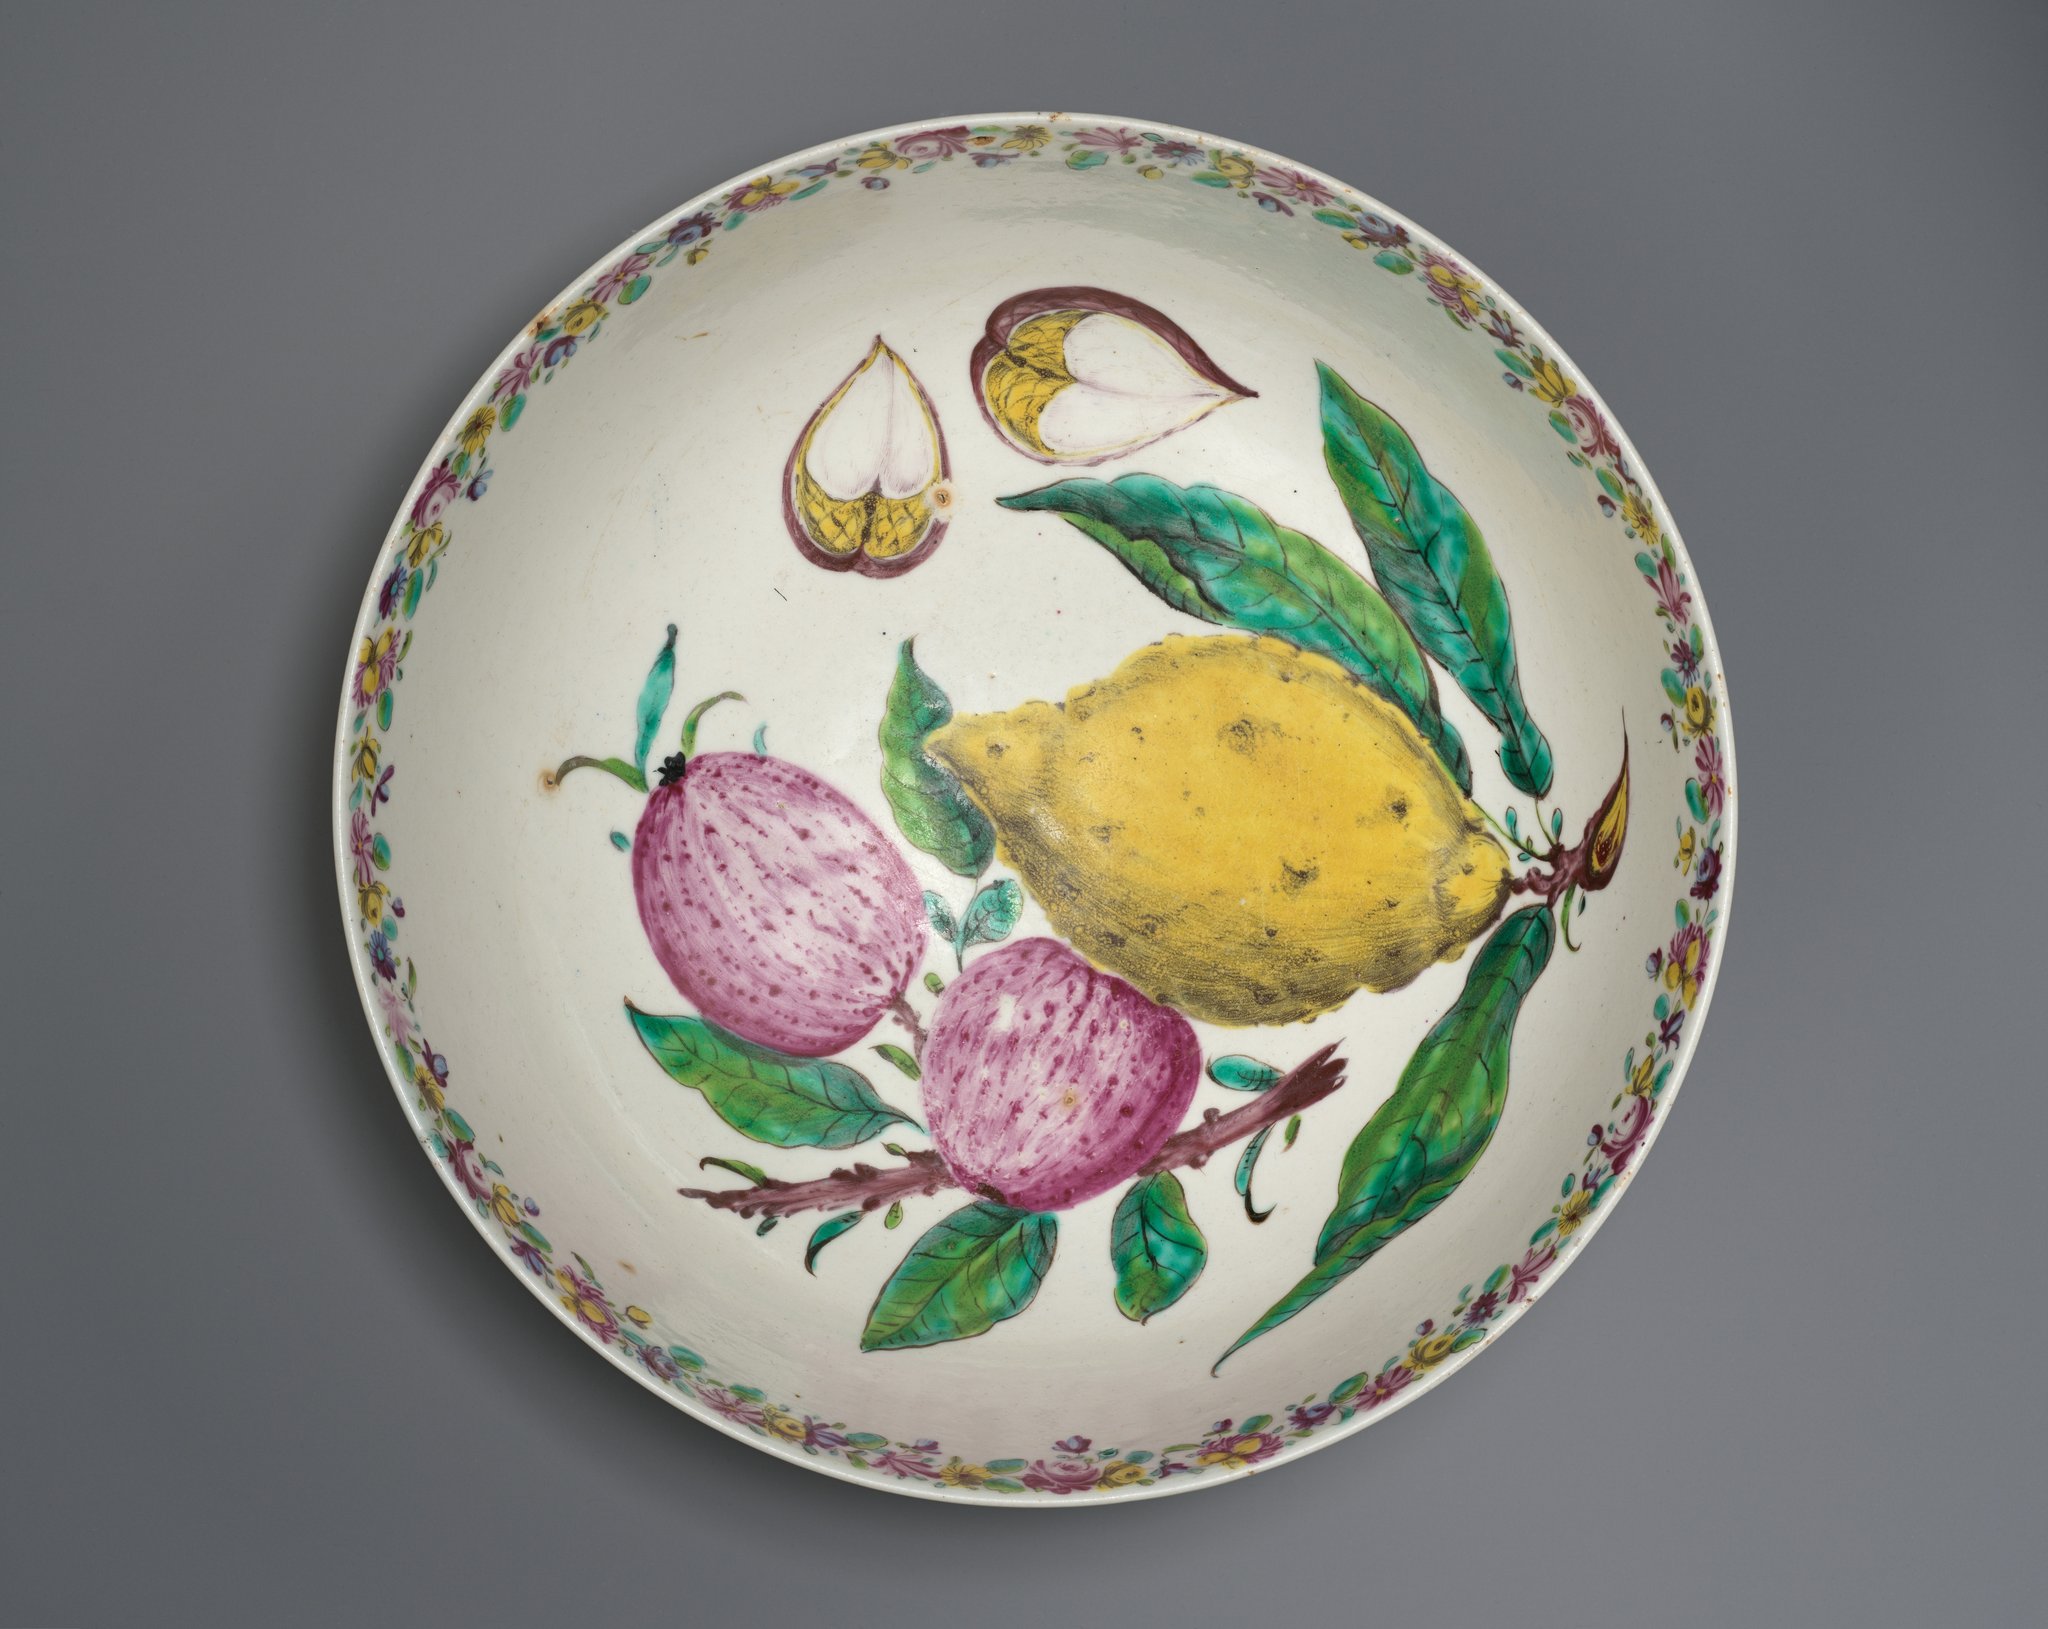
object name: marriage bowl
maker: bow porcelain factory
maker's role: factory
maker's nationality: british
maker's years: 1747-1776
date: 1761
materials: soft paste porcelain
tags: fruit,lemons